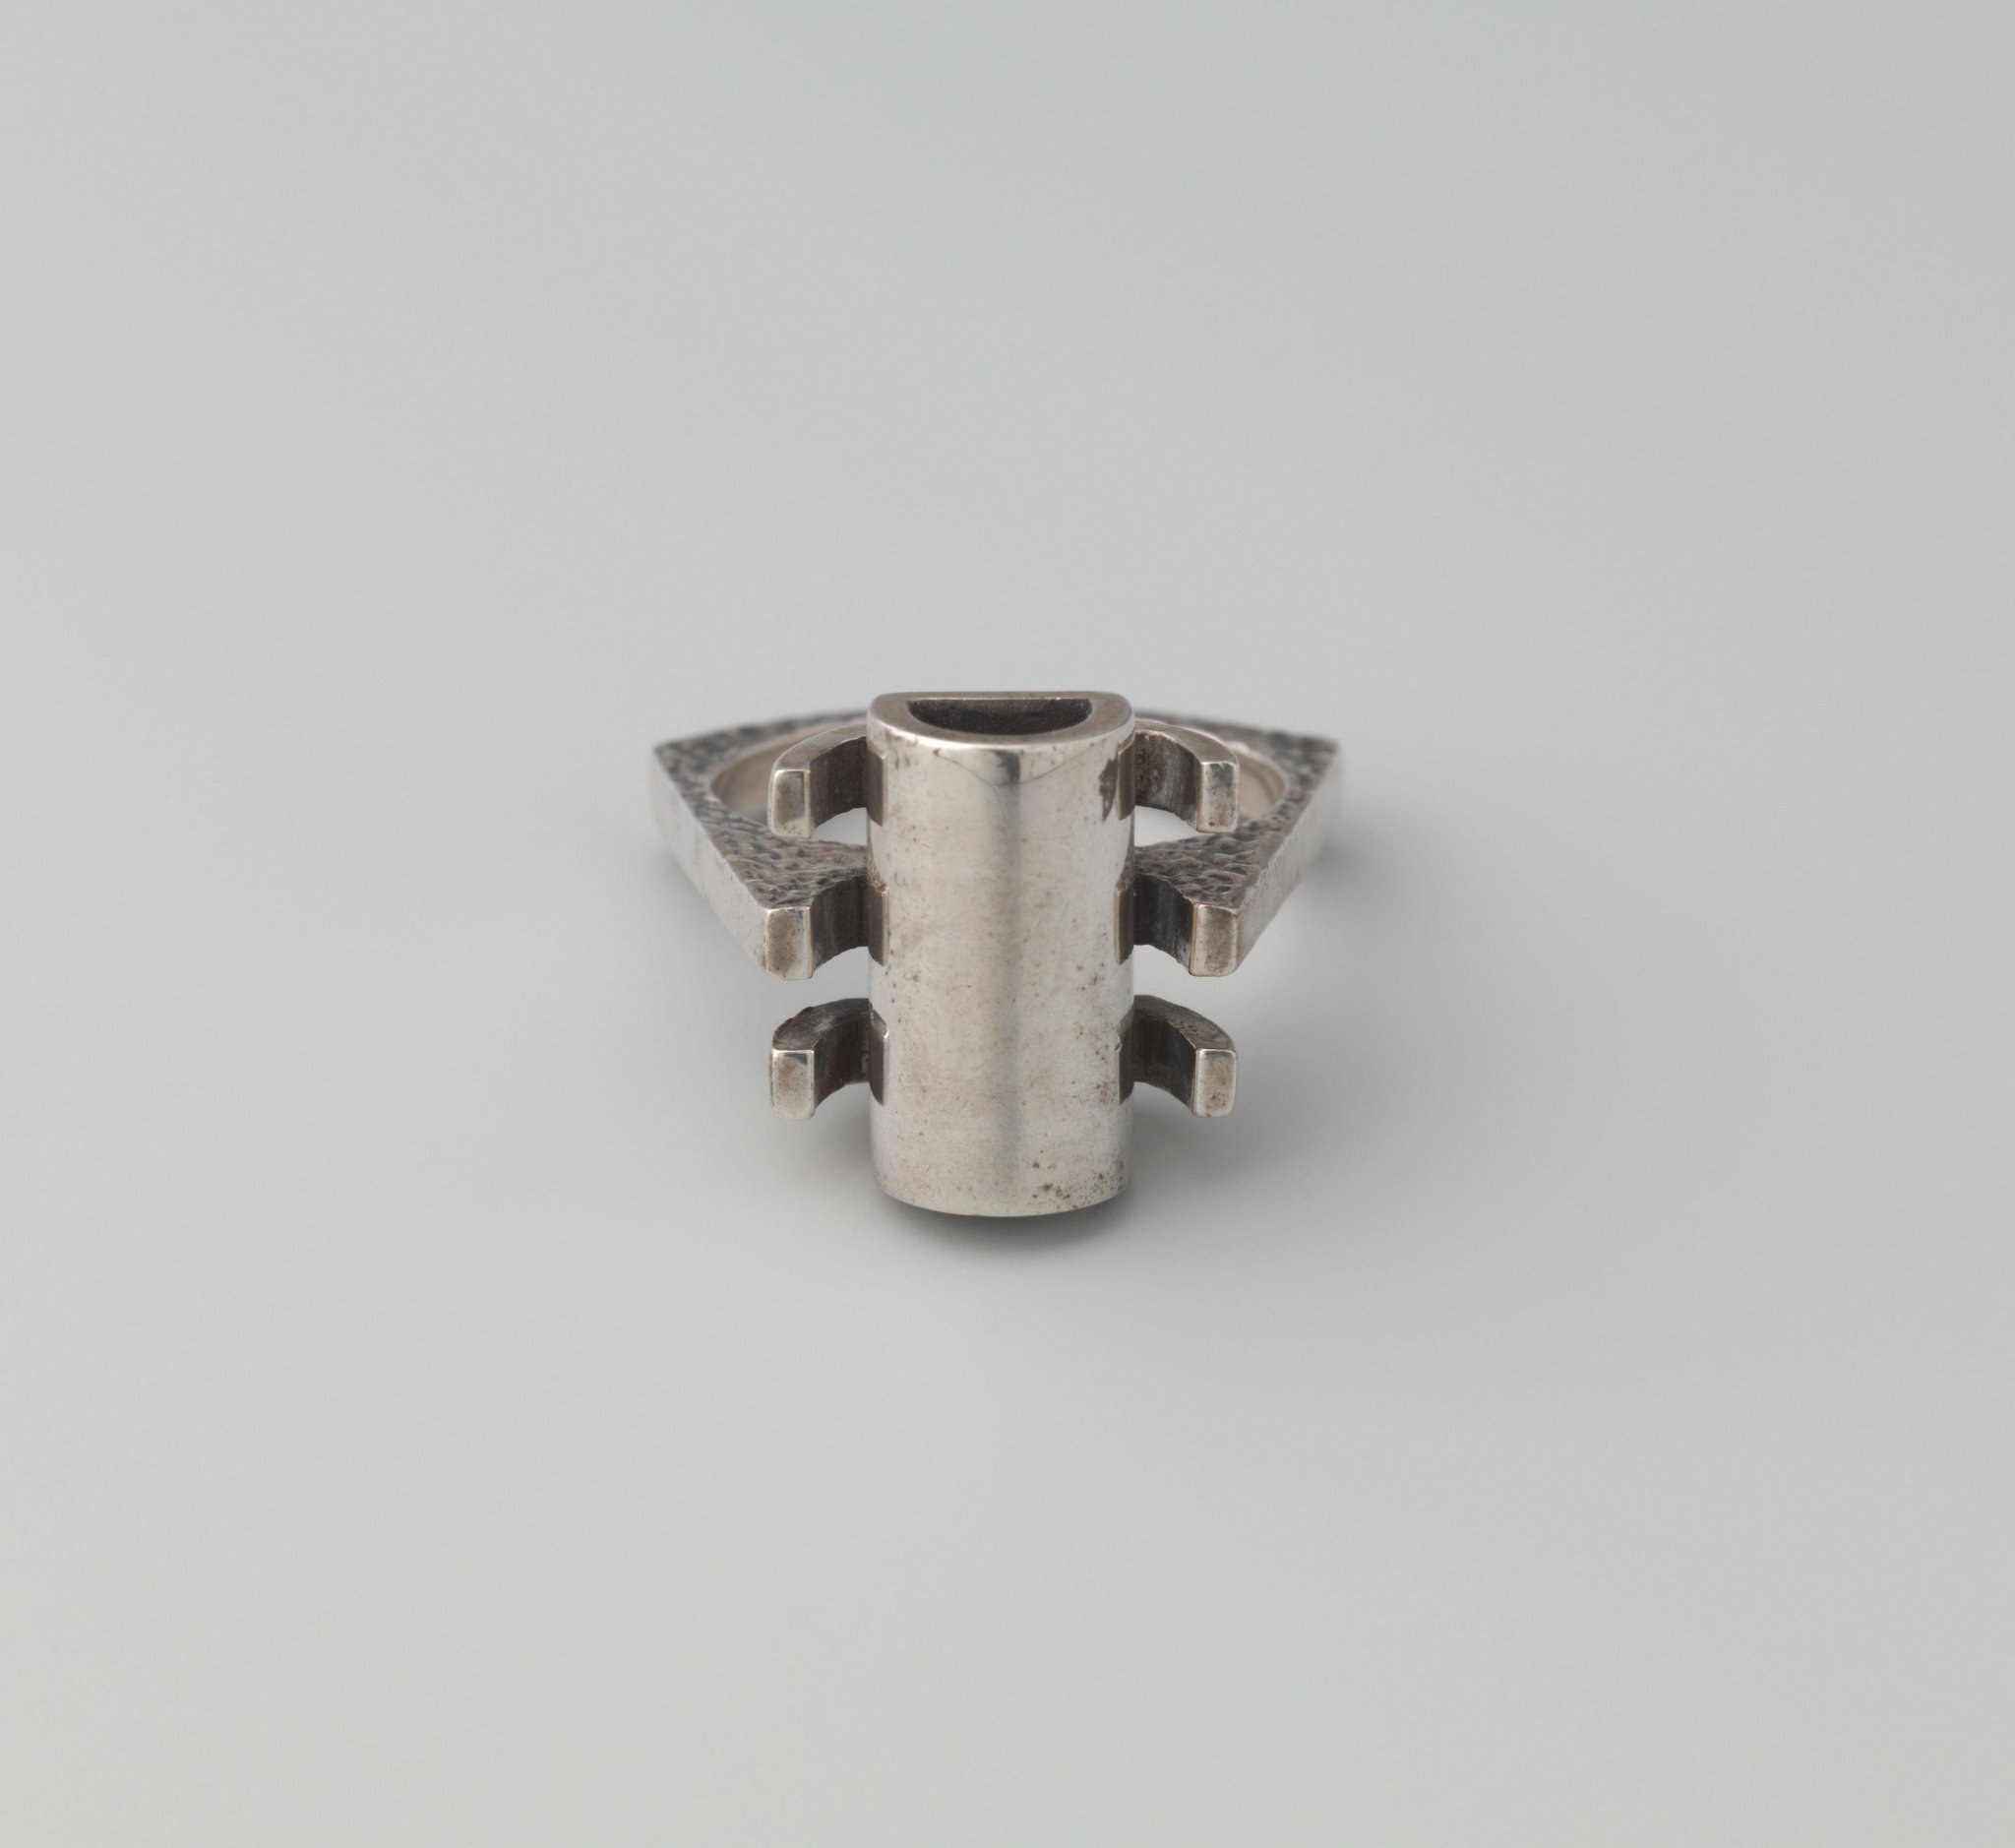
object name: ring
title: Tienerring met buisvorm met zes uitsteeksels als knop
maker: Anonymous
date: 1960-1970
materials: silver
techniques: blackening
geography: schoonhoven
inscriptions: alloy mark: ‘zwaard 835’, maker's mark: ‘N 10’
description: Tienerring met gladde buisvorm met zes uitsteeksels als knop.